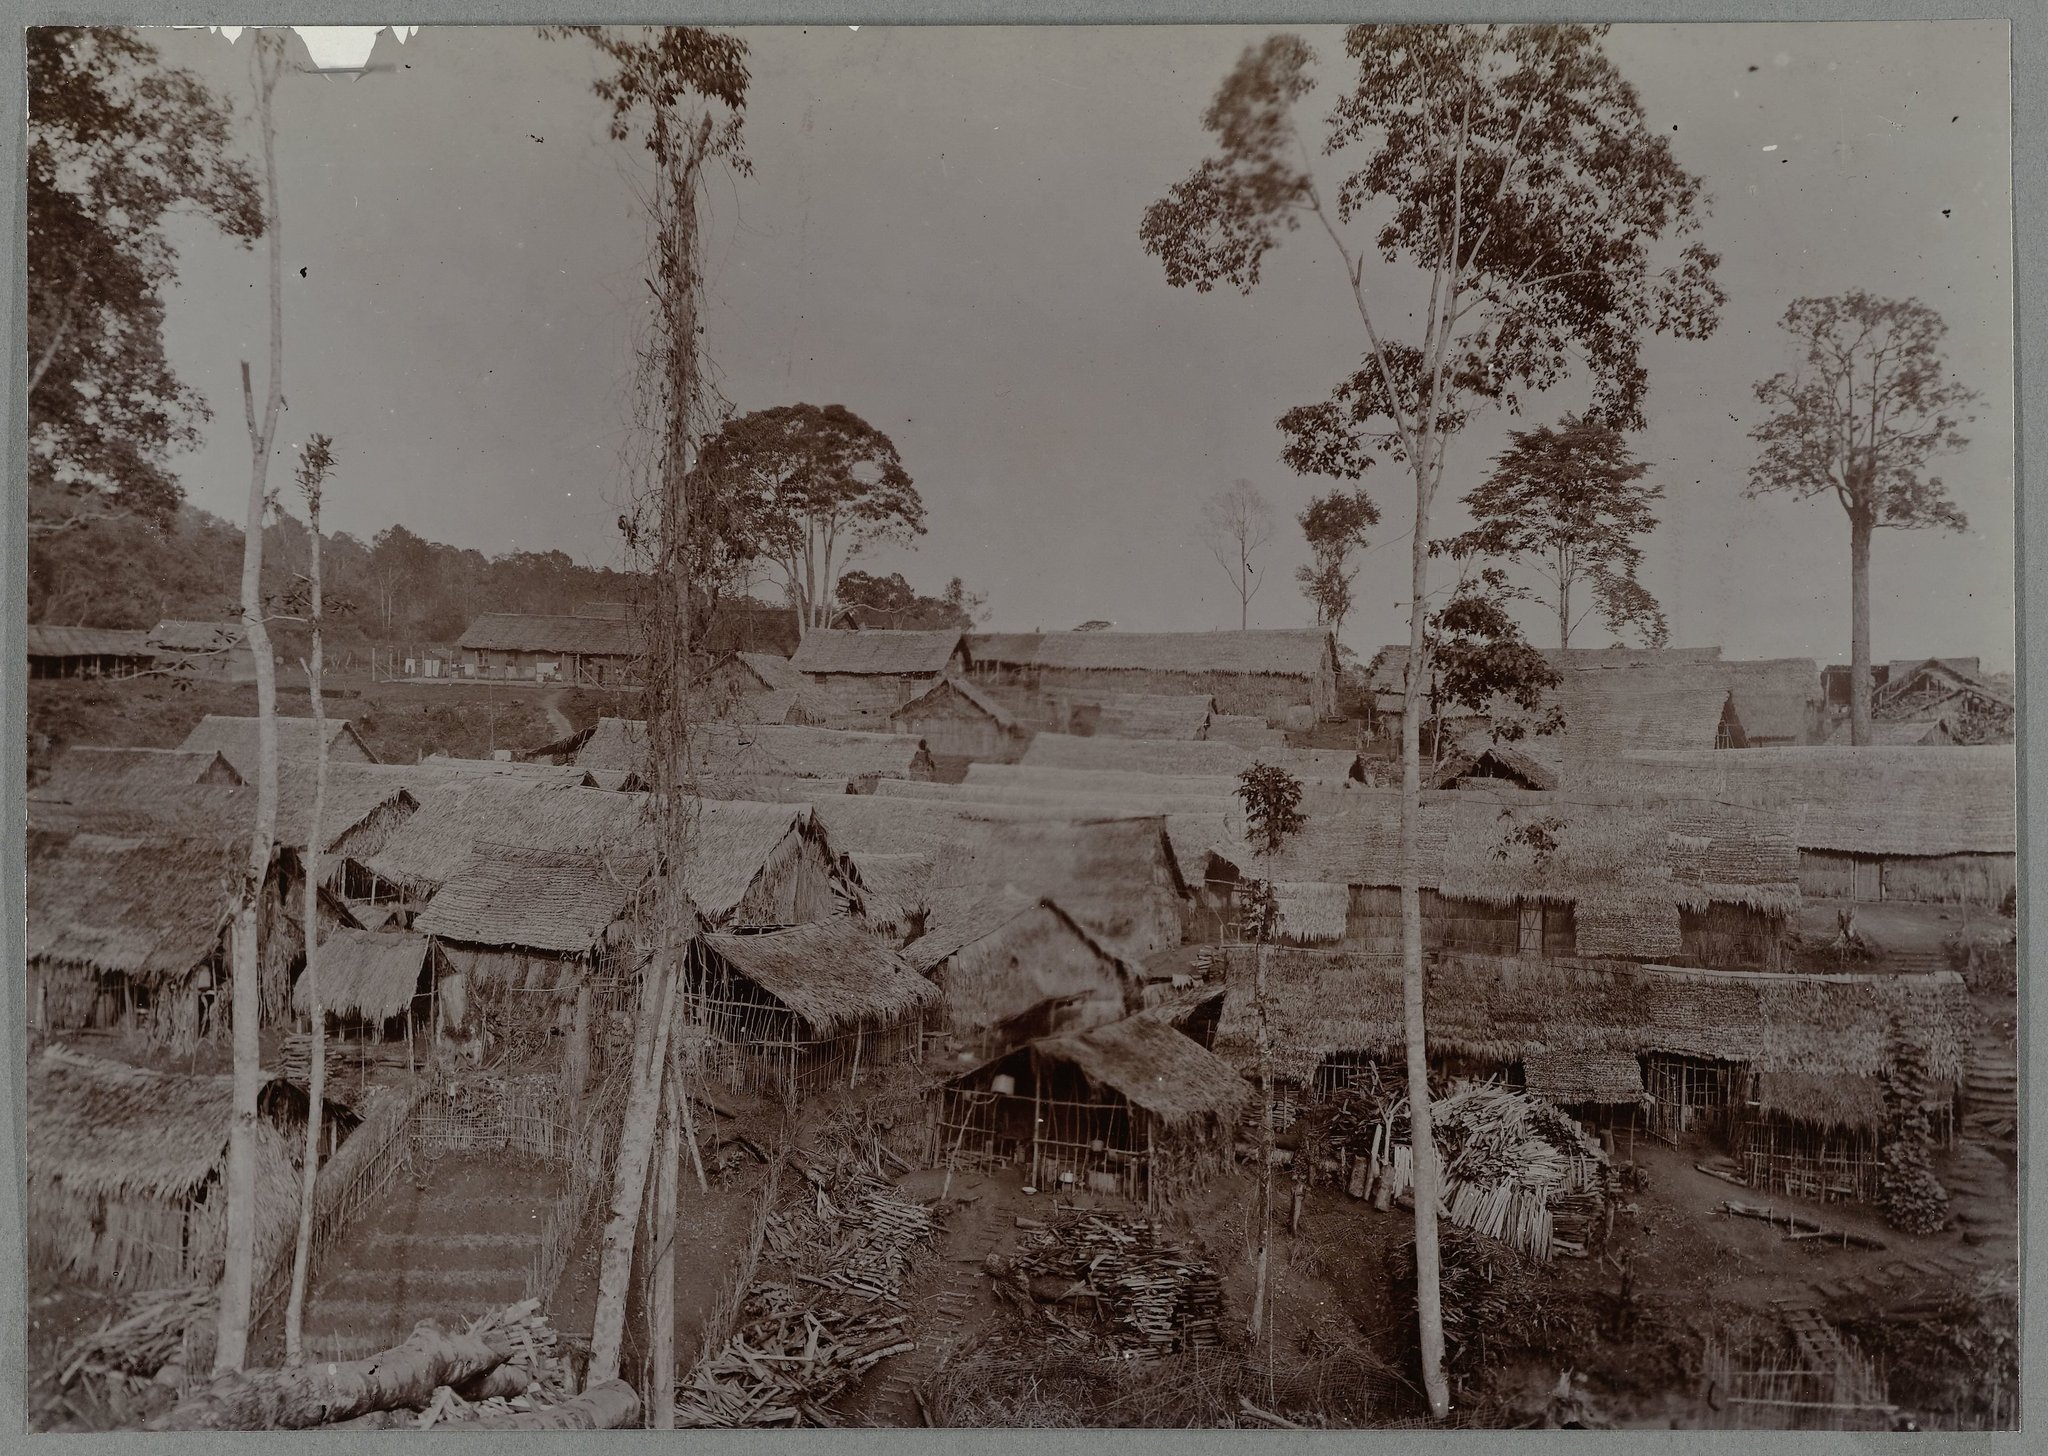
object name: photograph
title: Dorp bij Boer ni Poepandji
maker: Anonymous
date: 1903-1913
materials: photographic support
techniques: photography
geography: north sumatra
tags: arnhem, albertus dominicus laman trip, landscapes in tropical and sub-tropical regions, village, road, path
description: Na de expedities naar de Gajo- en Alaslanden o.l.v. Van Daalen (eerste tocht in 1901), werd hij in 1903 belast met voorbereiding van permanente vestiging van Nederlands gezag. Aanleg van een weg van de Noordkust naar het binnenland was hierbij van groot belang. Deze zgn. Gajoweg werd aangelegd tussen 1903 en 1914, van Bireuen aan de kust naar Takinguen aan het bergmeer Danau Lauttawar, totale lente 104 km.